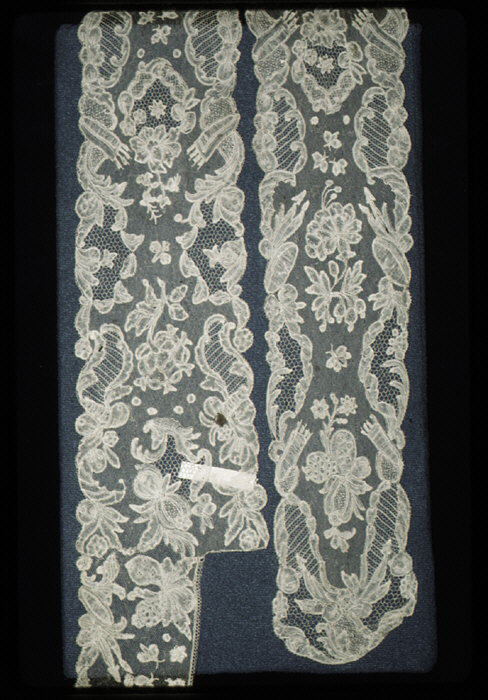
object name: lappet and papillon edging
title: Two joined lappets and papillon edging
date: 1734-1766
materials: lace, linen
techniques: lace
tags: flowers